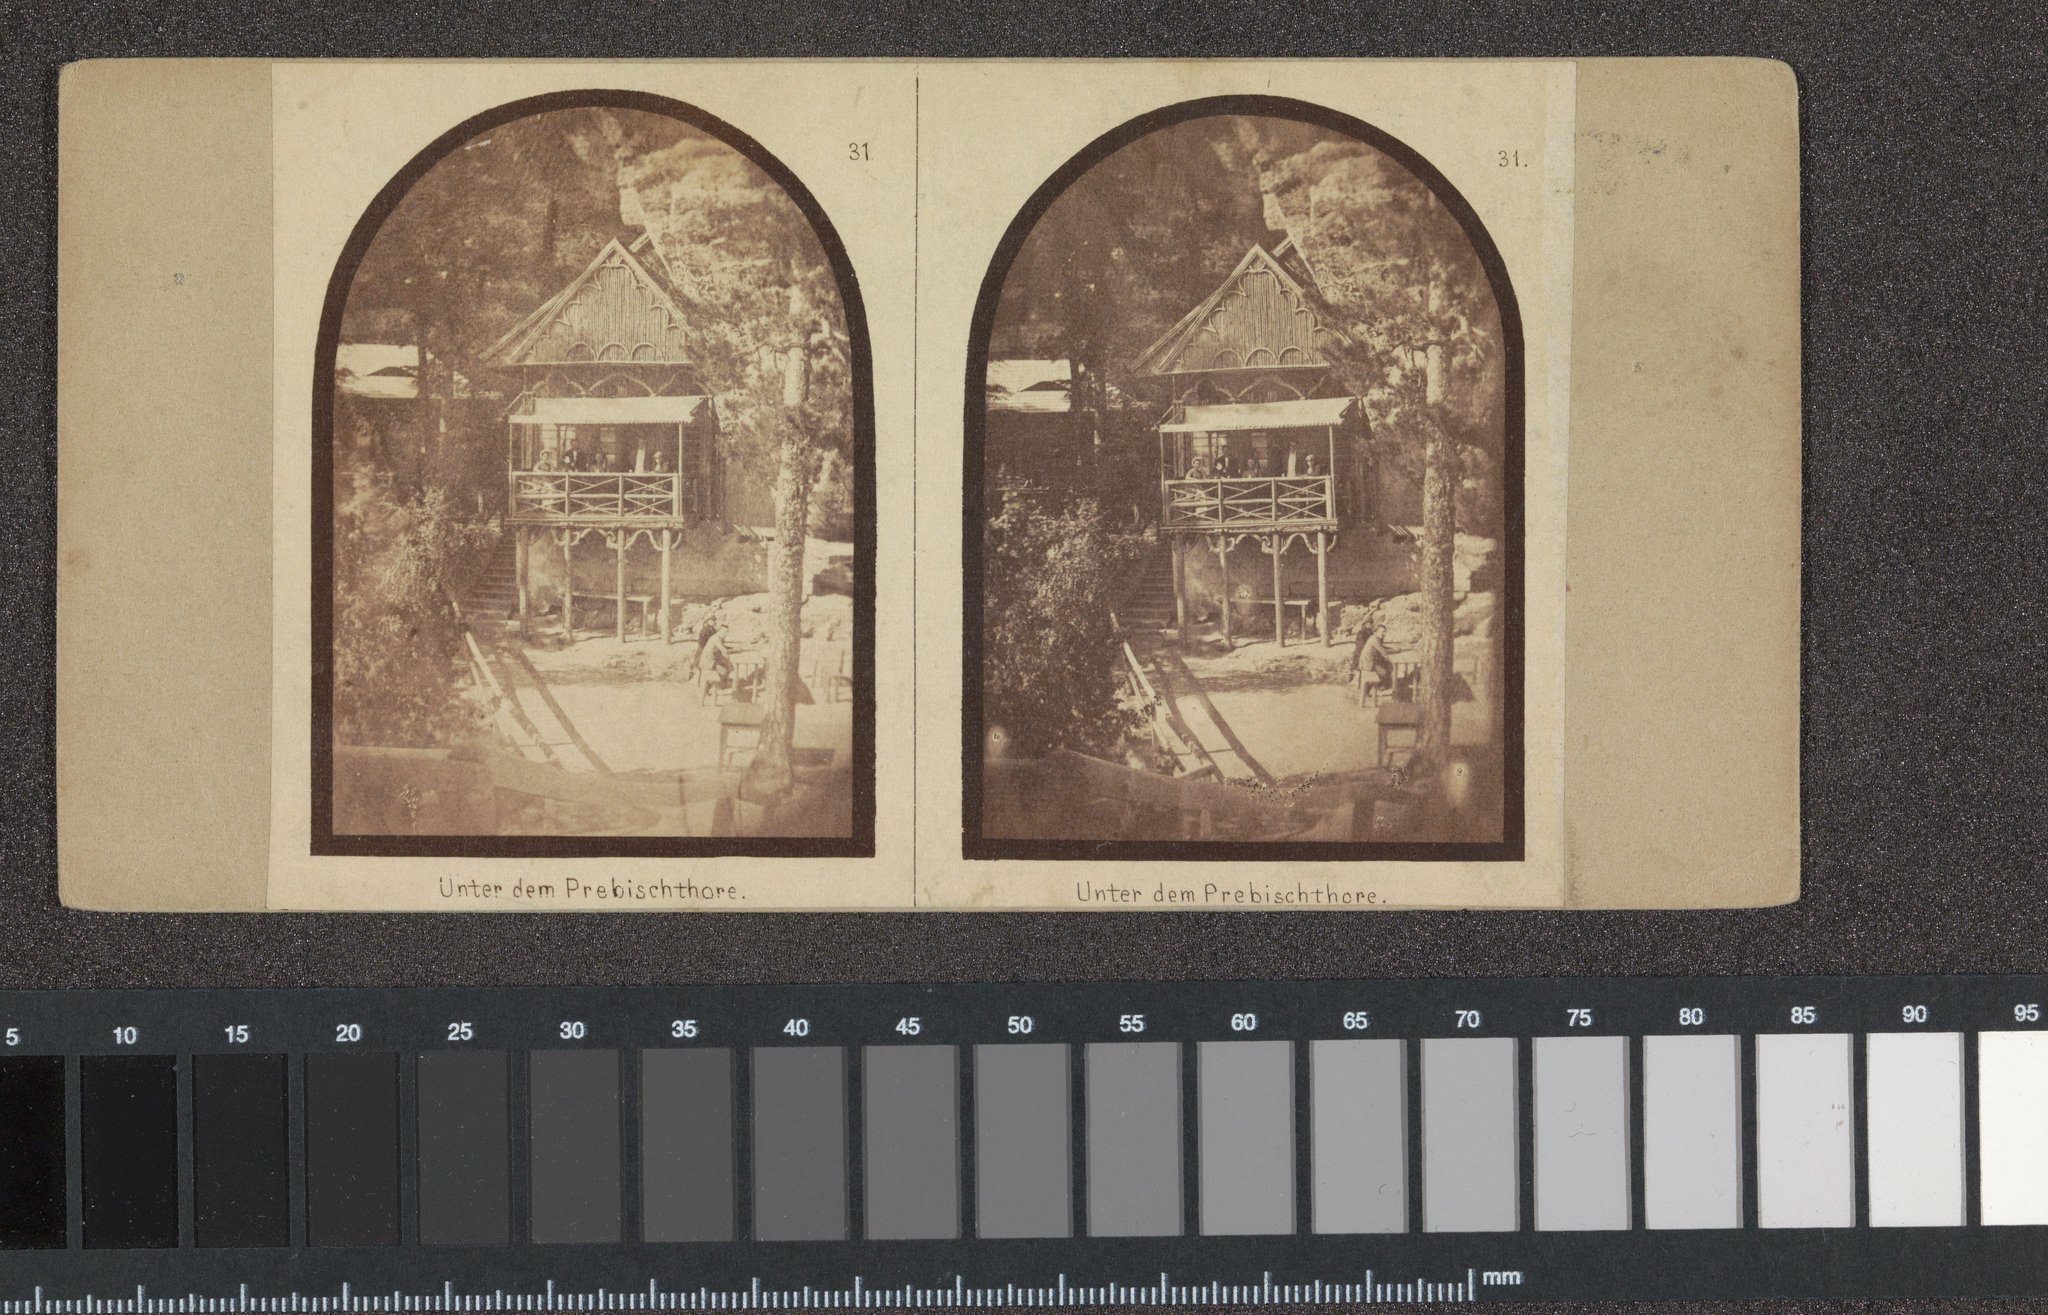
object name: stereograph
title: Gebouw onder de rotsformatie Prebischtor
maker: Anonymous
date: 1855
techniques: albumen print, salted paper print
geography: czech republic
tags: rock-formations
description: De Prebischthor (Pravčická brána) ligt in het huidige Tsjechië op de grens met Duitsland.